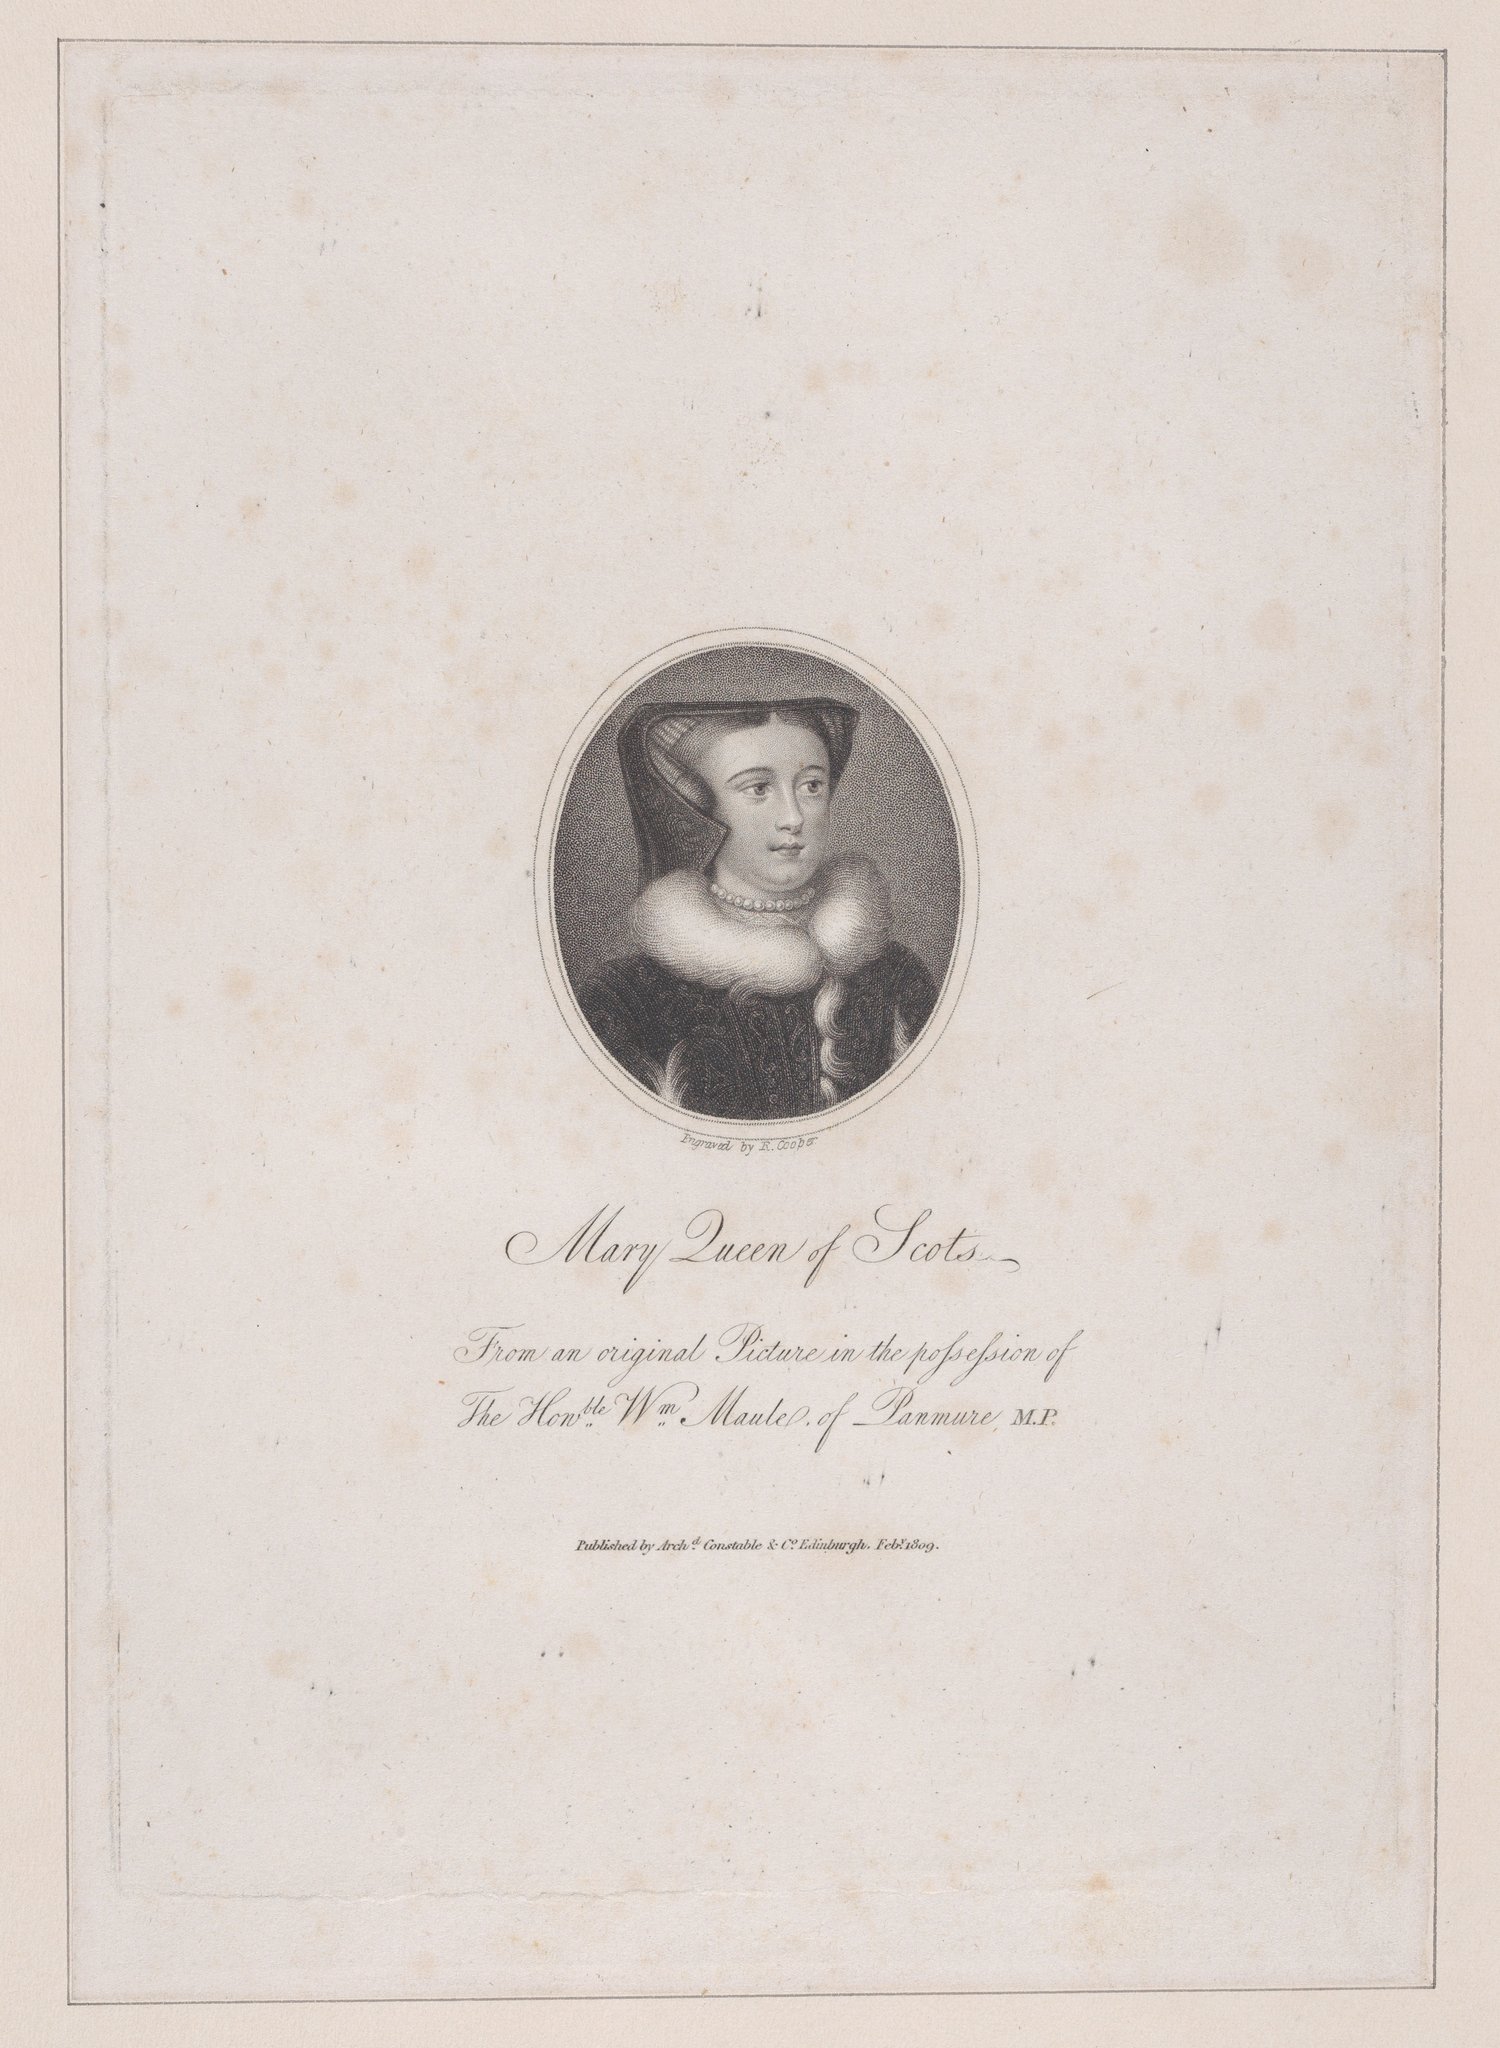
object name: print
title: Mary, Queen of Scots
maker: robert cooper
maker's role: artist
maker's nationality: british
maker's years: -1828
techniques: engraving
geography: scotland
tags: queens,portraits,women,mary queen of scots